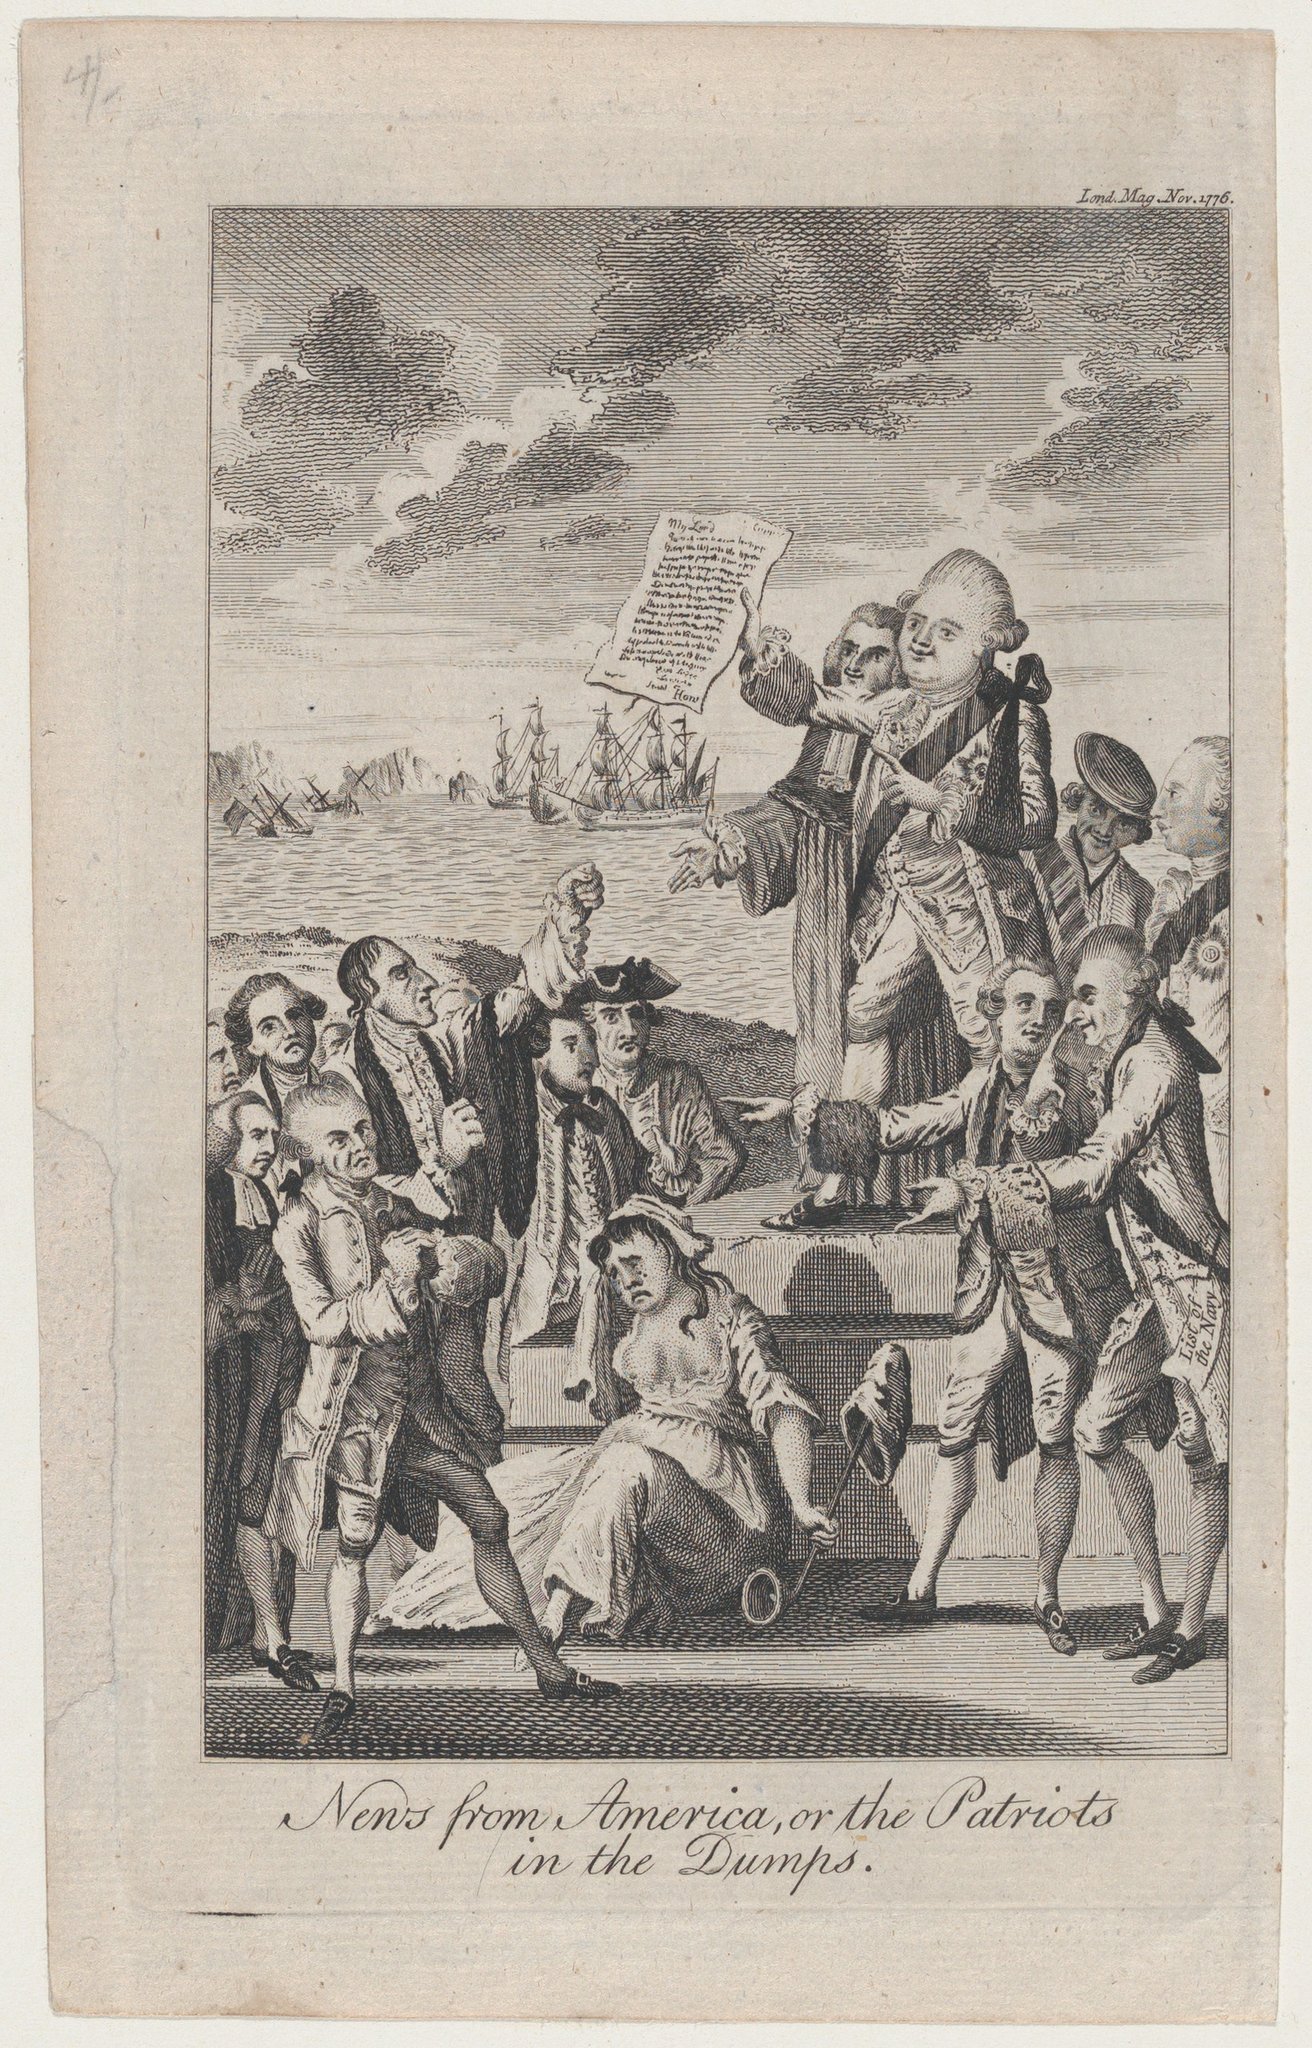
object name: print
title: News from America, or the Patriots in the Dumps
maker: anonymous, british, 18th century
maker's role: artist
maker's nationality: british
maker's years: 1700-1800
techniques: engraving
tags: satire,american revolution,men,women,politics